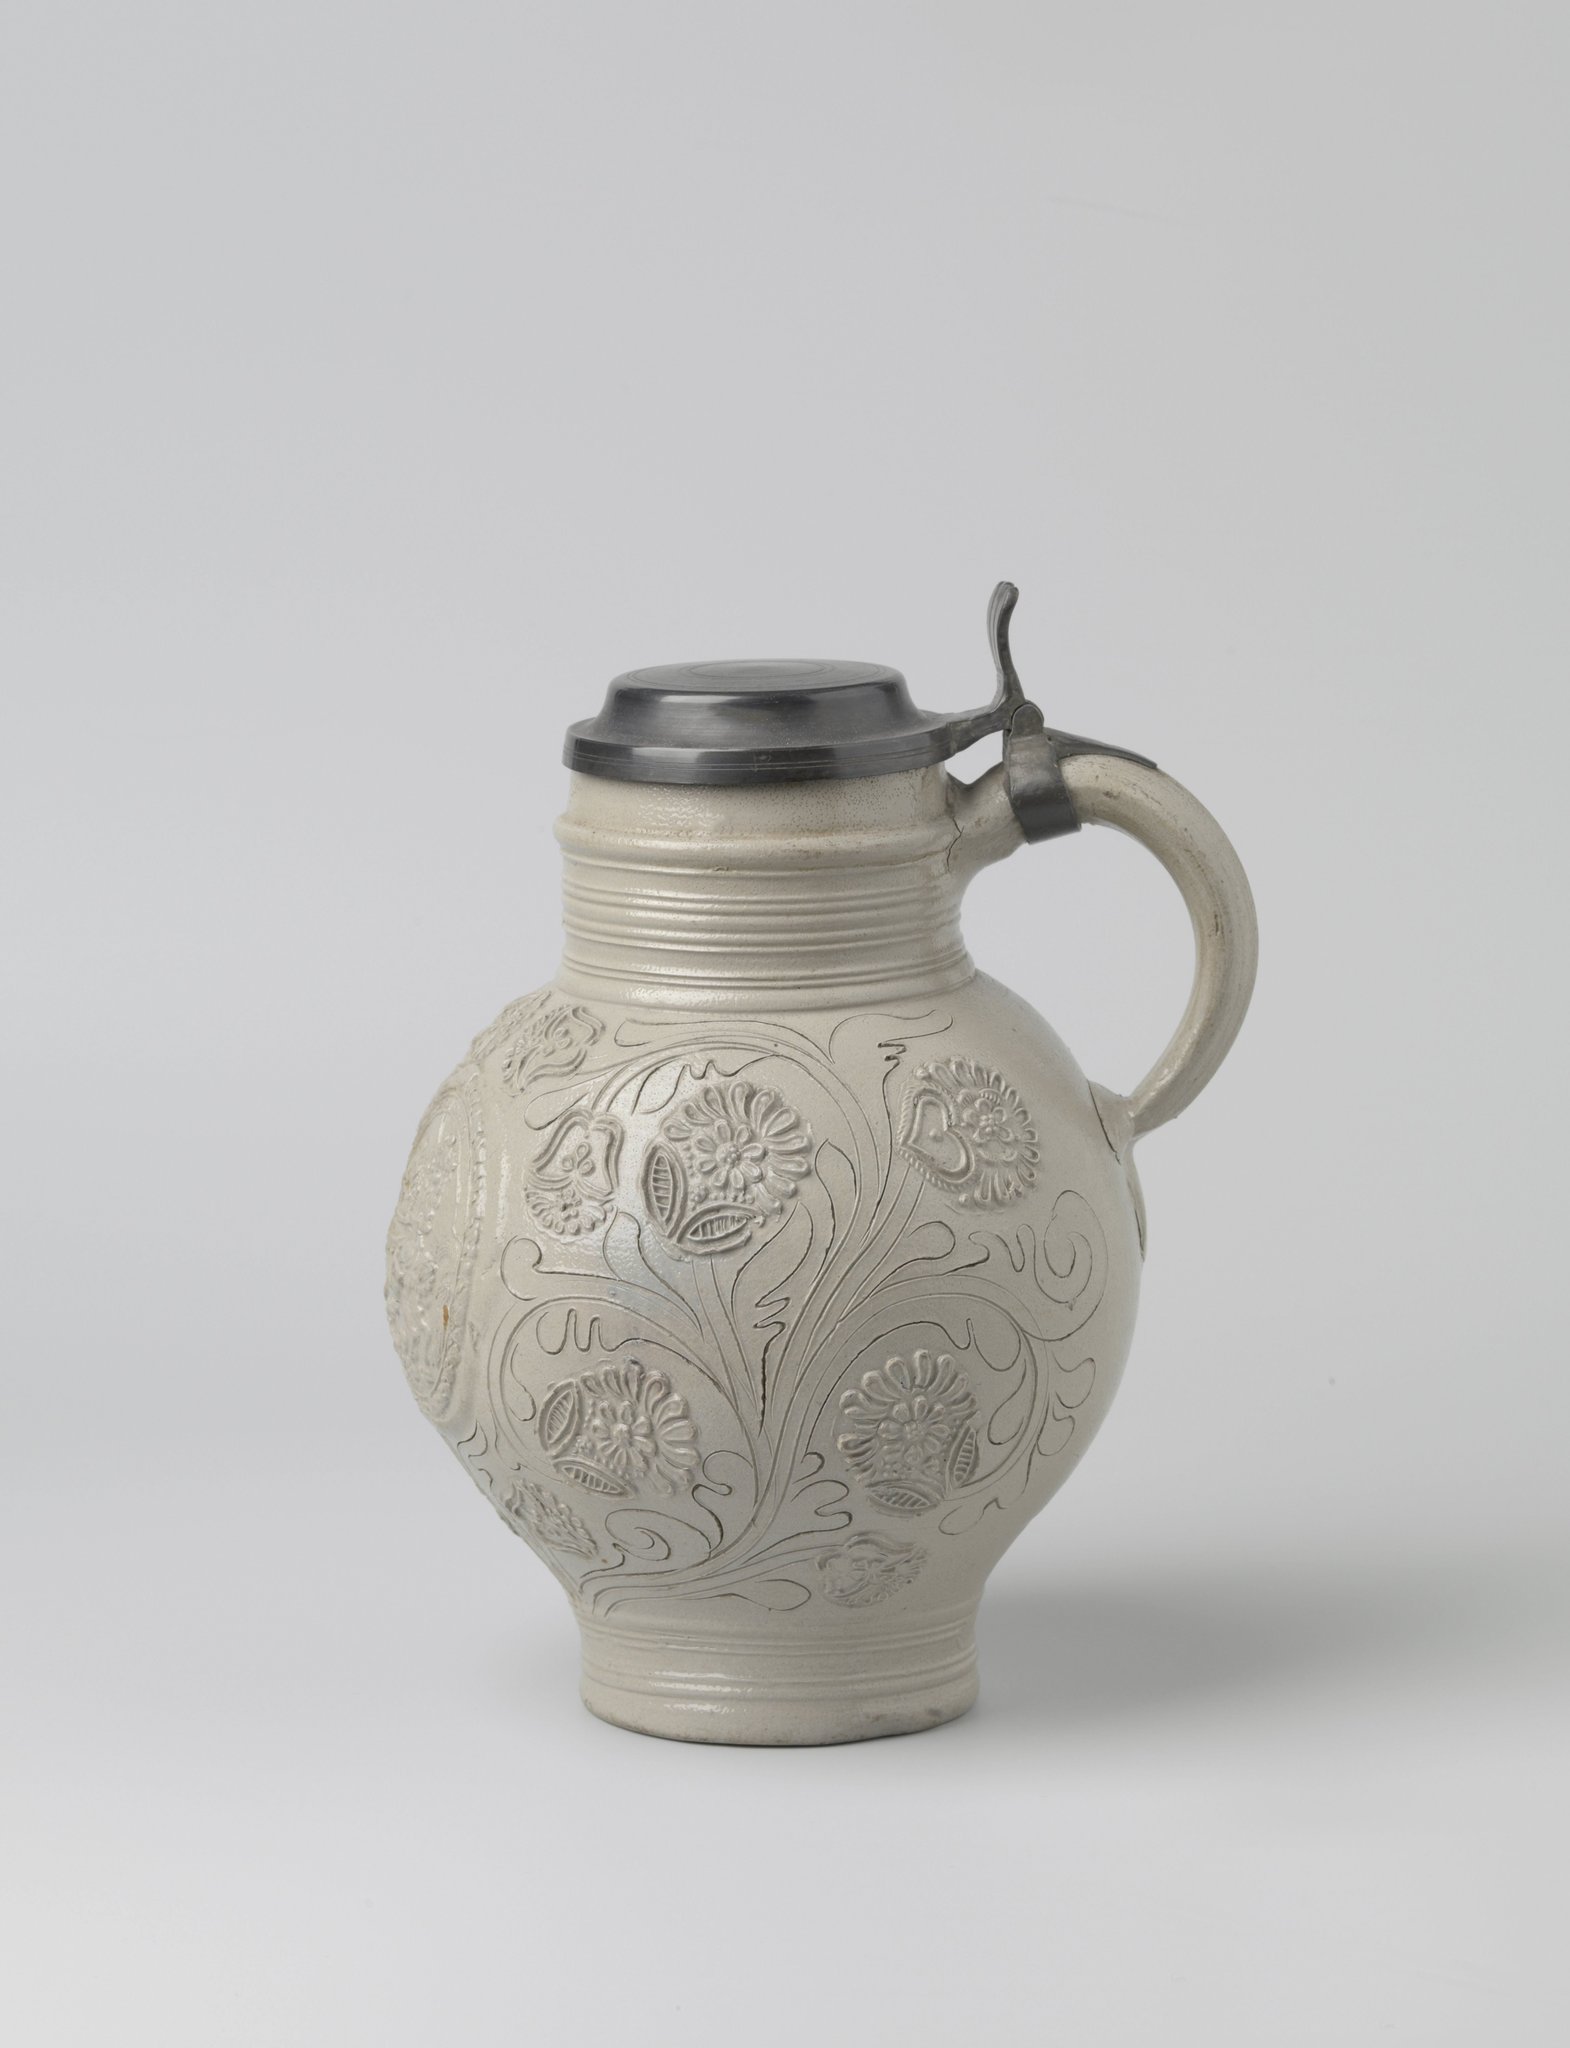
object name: jug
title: Jug with a portrait among floral scrolls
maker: Anonymous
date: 1675-1724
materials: glaze, stoneware, tin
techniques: firing, forming, relief, turning, vitrification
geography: westerwald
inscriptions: inscription: ‘[...]AR HEN FRISO PRIN’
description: Kruik van steengoed op hoge voet met bolvormige buik en korte, wijde nek. Het C-vormige oor is bevestigd aan de nek en de buik. Enkele profielen en ingegrifte lijnen op de voet en nek. Op de voorzijde van de buik een gedrukt en opgelegd medaillon met een portret van een ruiter met hond en het onvolledige opschrift '[...]AR HEN FRISO PRIN'. Om het medaillon een bloeiende plant. De bladranken zijn ingegrift en de bloemen zijn gedrukt en opgelegd in reliëf. Bevestigd aan het oor een tinnen montuur met deksel. Westerwald.